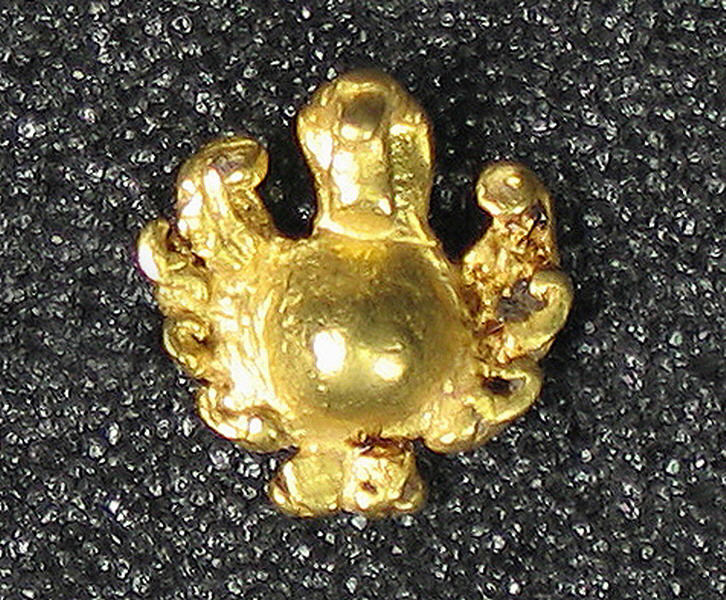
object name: earring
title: Bird-Form Earring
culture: indonesian, central java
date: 701-1200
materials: gold